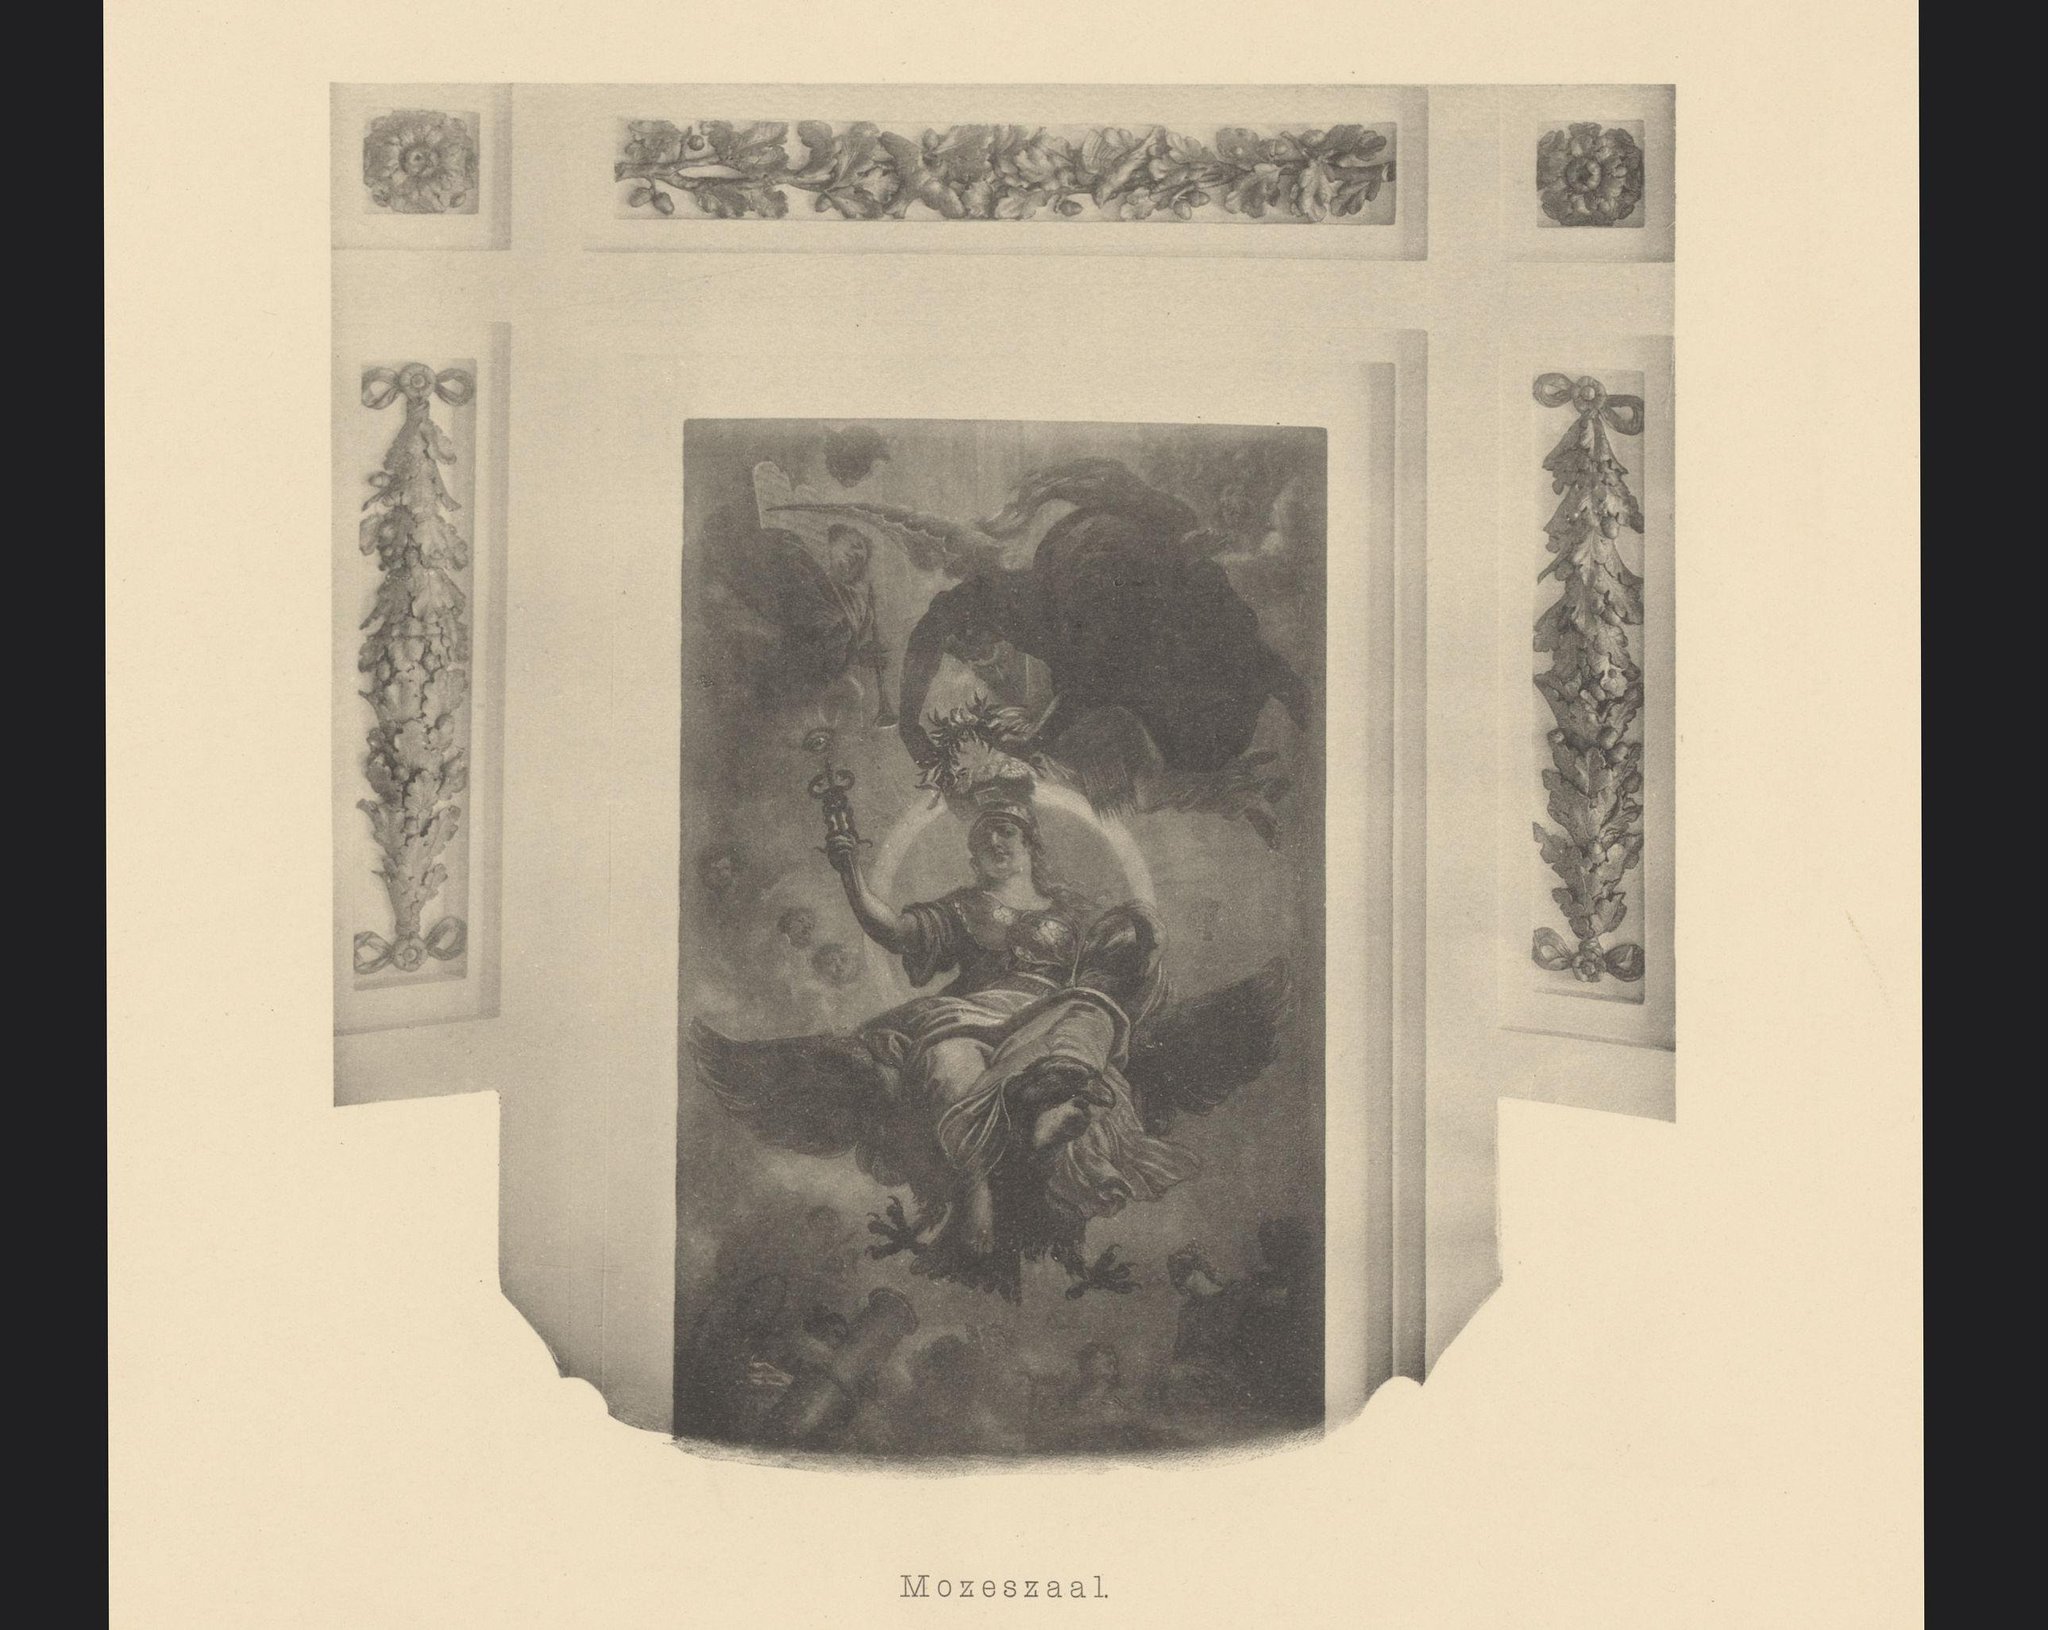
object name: photograph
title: C.T.J. Louis Rieber, Het Koninklijk Paleis te Amsterdam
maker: Anonymous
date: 1899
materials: cardboard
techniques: photograph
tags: palace, interior of the house, picture, painting, royal palace of amsterdam